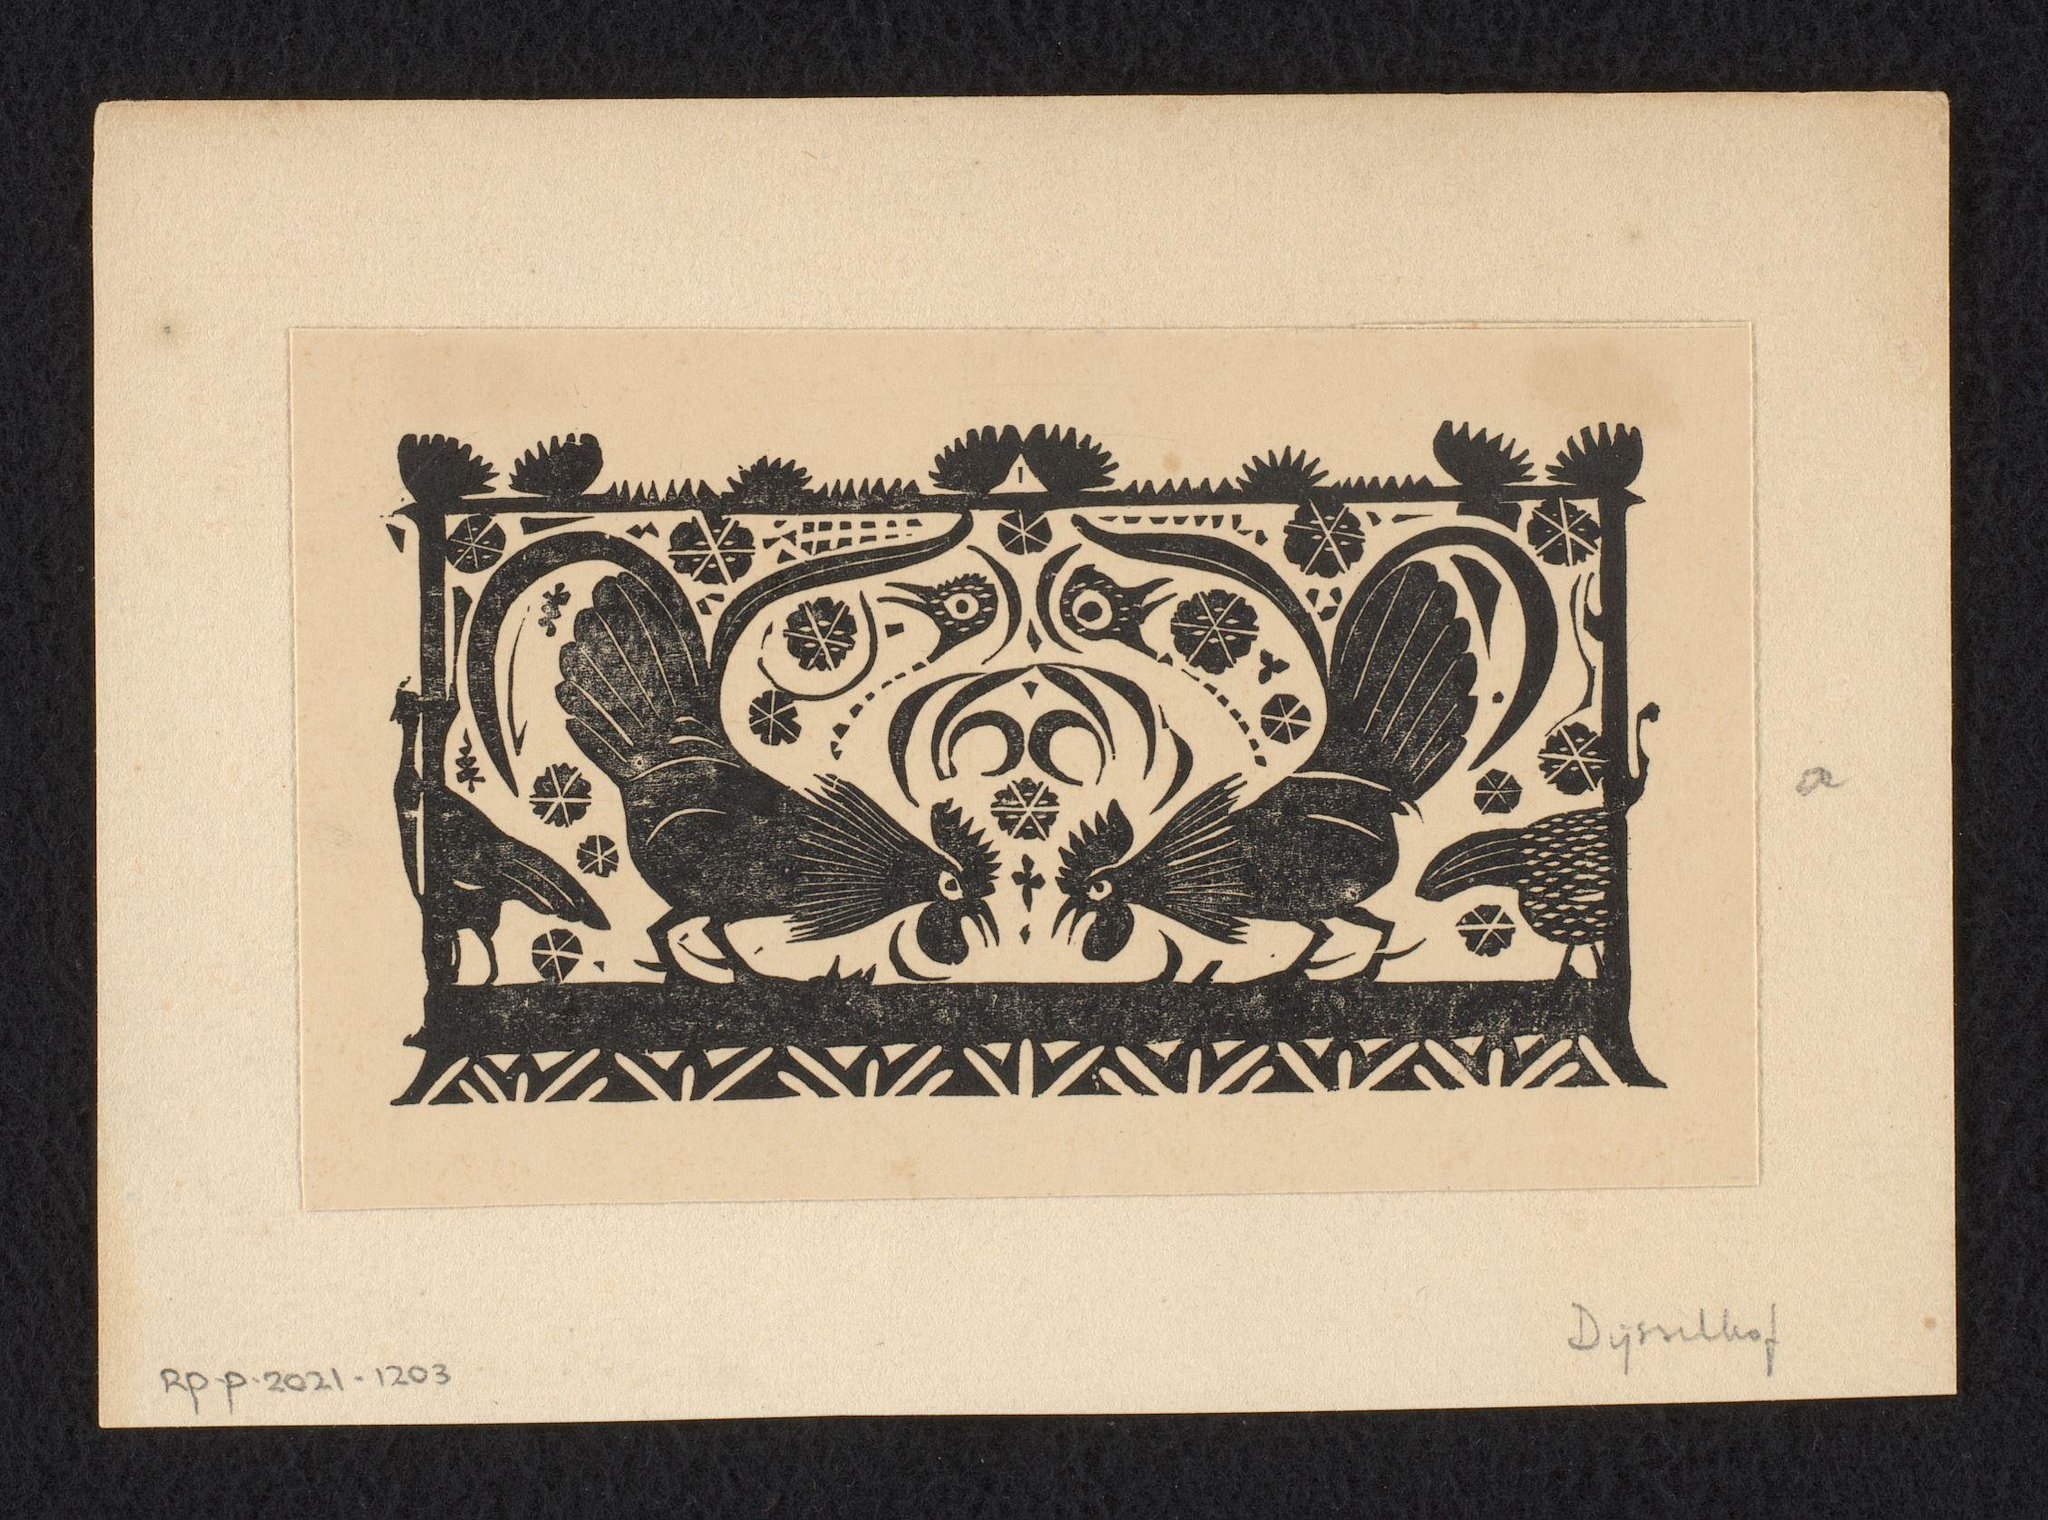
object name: book illustration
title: Titelhoofd met hanen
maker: gerrit willem dijsselhof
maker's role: designer, draughtsman, print maker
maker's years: 1866-1924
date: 1893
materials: paper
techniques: galvanoplasty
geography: haarlem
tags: flowers ~ ornament - aa - stylized, fowl (cock, hen, chicken, etc.)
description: Titelhoofd uit: Crane, Walter. Kunst en samenleving. [Vertaald uit het Engels door] Jan Veth. Amsterdam: Scheltema & Holkema's Boekhandel, 1894 [1893], p. 61. Later zijn deze afbeeldingen door de uitgever veelvuldig gebruikt voor andere uitgaven. Zie bijvoorbeeld RP-P-1969-415, een catalogus van de in 1894 bij Scheltema & Holkema's Boekhandel verkrijgbare publicaties.